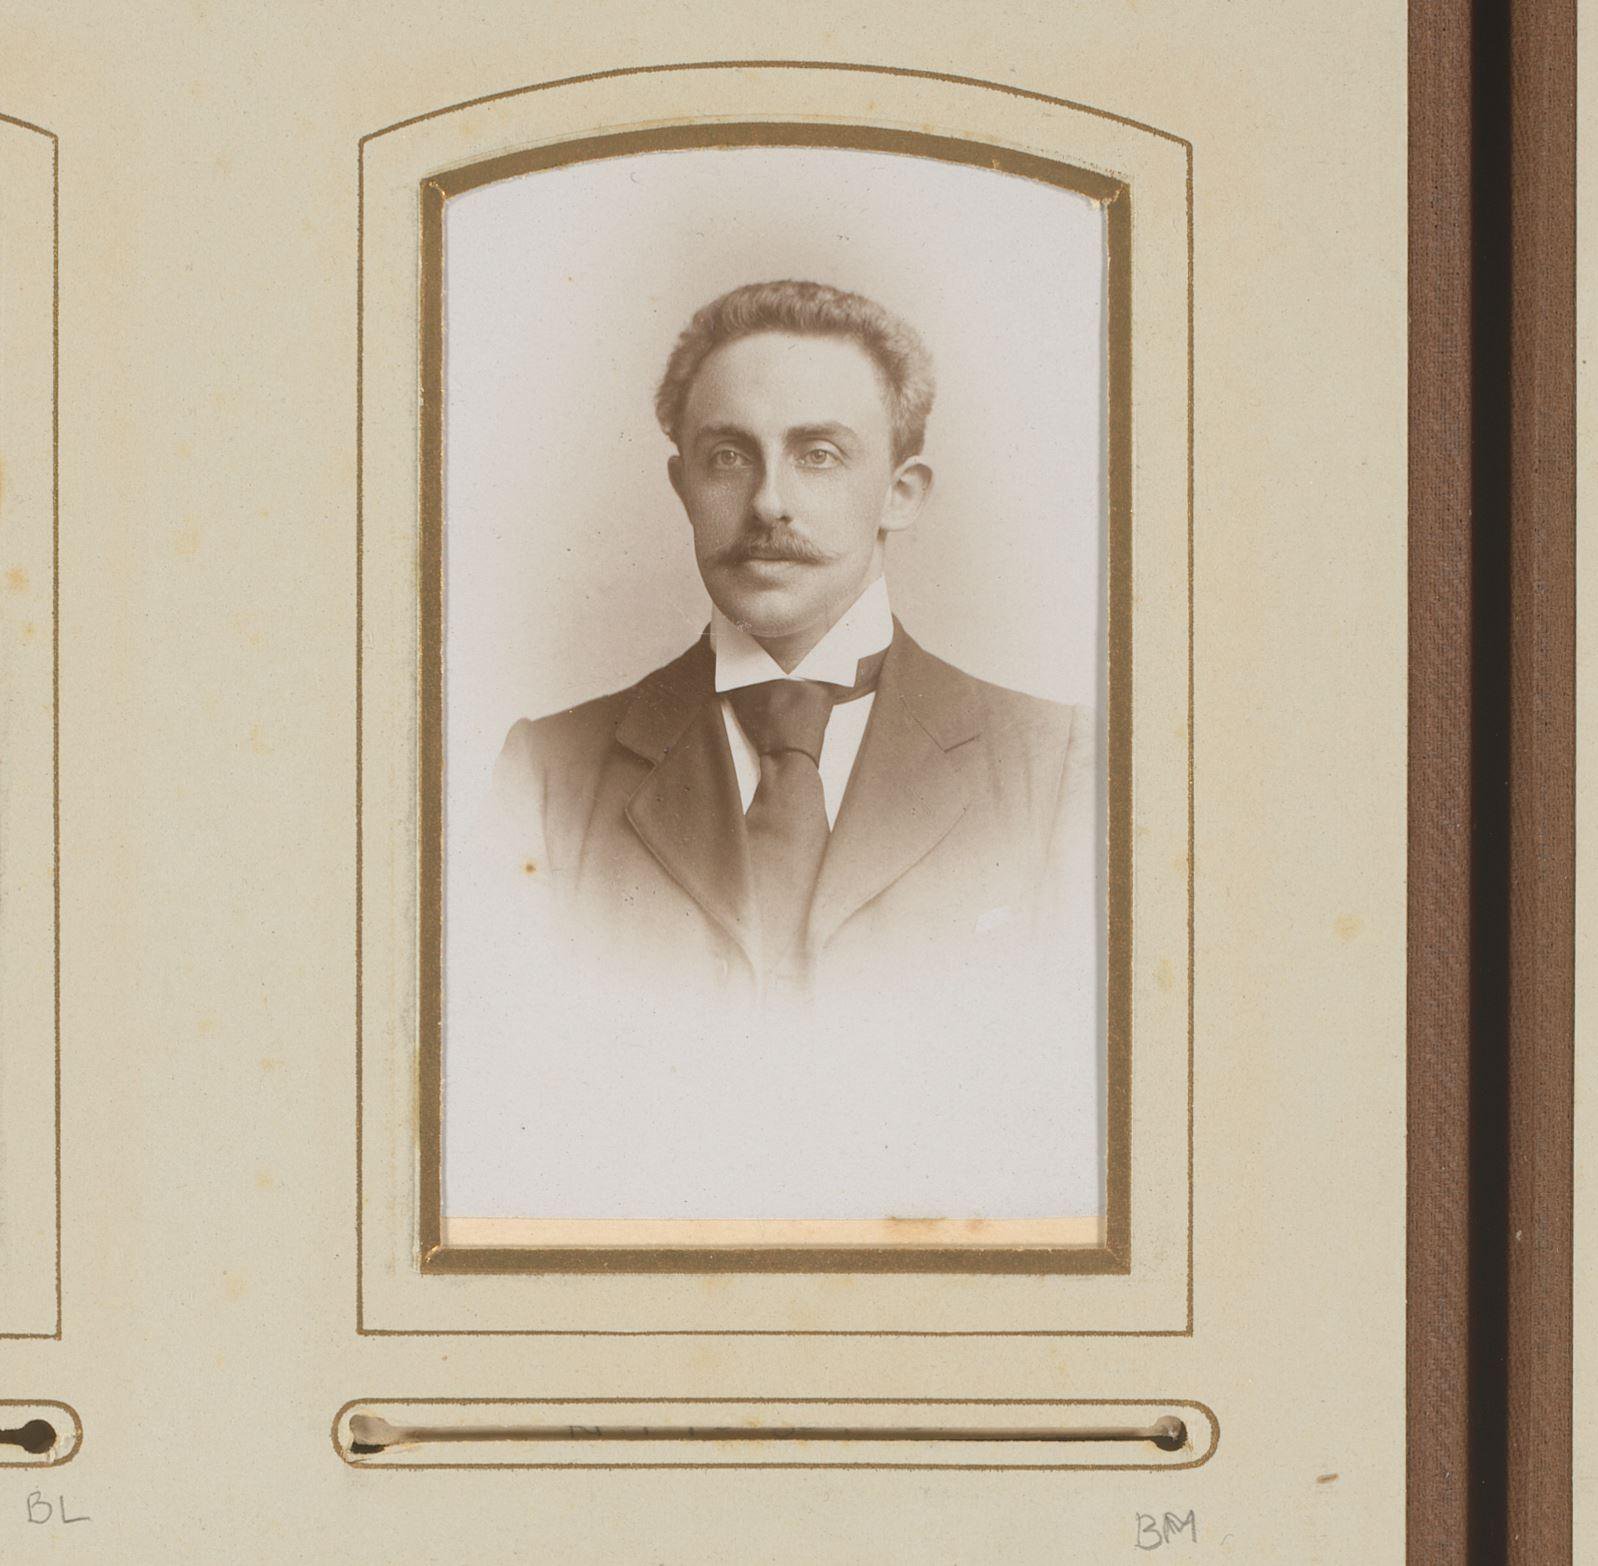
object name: carte de visite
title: Portret van een man met snor en stropdas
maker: camillus franciscus van der aa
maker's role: painter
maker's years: 1847-1915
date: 1880-1915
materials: cardboard, photographic support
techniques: collodion silver print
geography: alkmaar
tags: moustache, historical persons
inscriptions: inscription: ‘Atelier l'Espérance/ (...)/ C. van der Aa/ Photograaf/ Alkmaar./ Langestraat A.30/ Breedstraat bij de R.C. Kerk./’